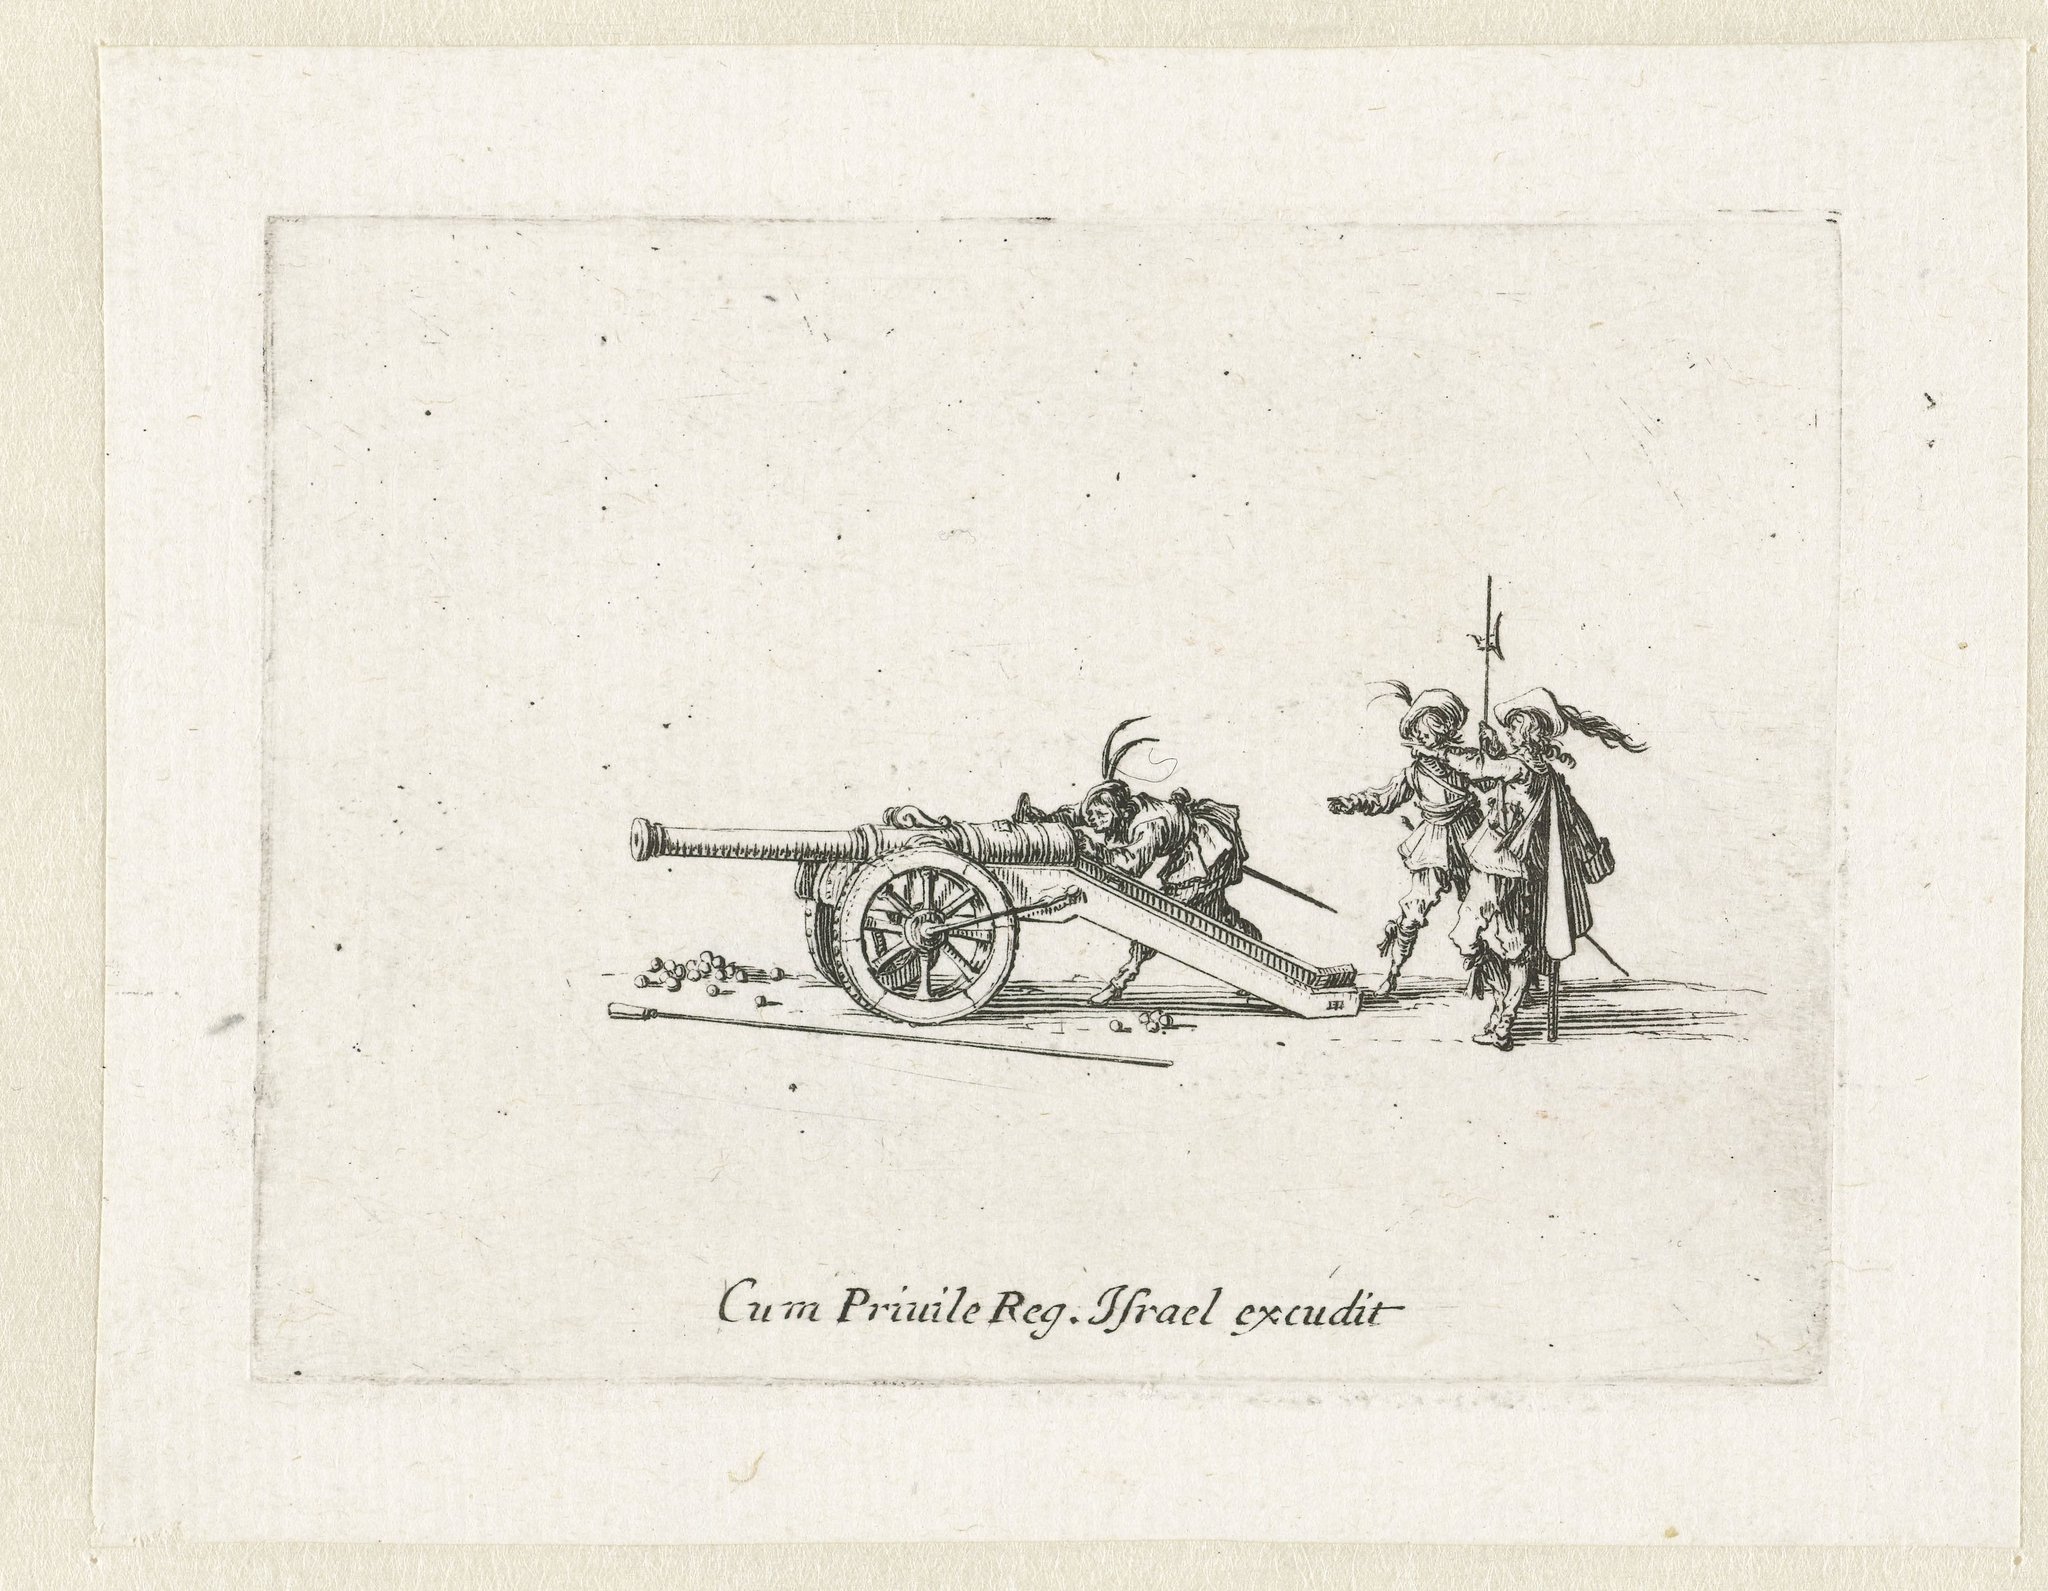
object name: print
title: Militaire exercities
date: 1635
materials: paper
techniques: etching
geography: paris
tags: handling of weapons ~ military training, firearms: cannon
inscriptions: collector's mark: Lugt 240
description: Twee soldaten staan rechts van een kanon. Een derde staat gebogen bij het kanon. Deze prent is onderdeel van een serie van 12 (13 incl. titelprent) prenten met voorstellingen van militaire (wapen)exercities. Op de meeste van die prenten staan drie soldaten in verschillende houdingen met een bepaald wapen of instrument.